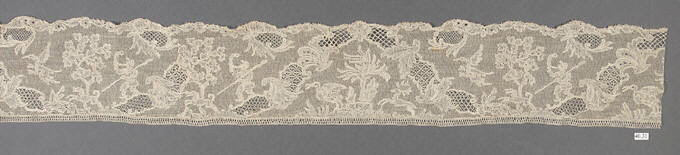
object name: border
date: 1701-1800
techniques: lace